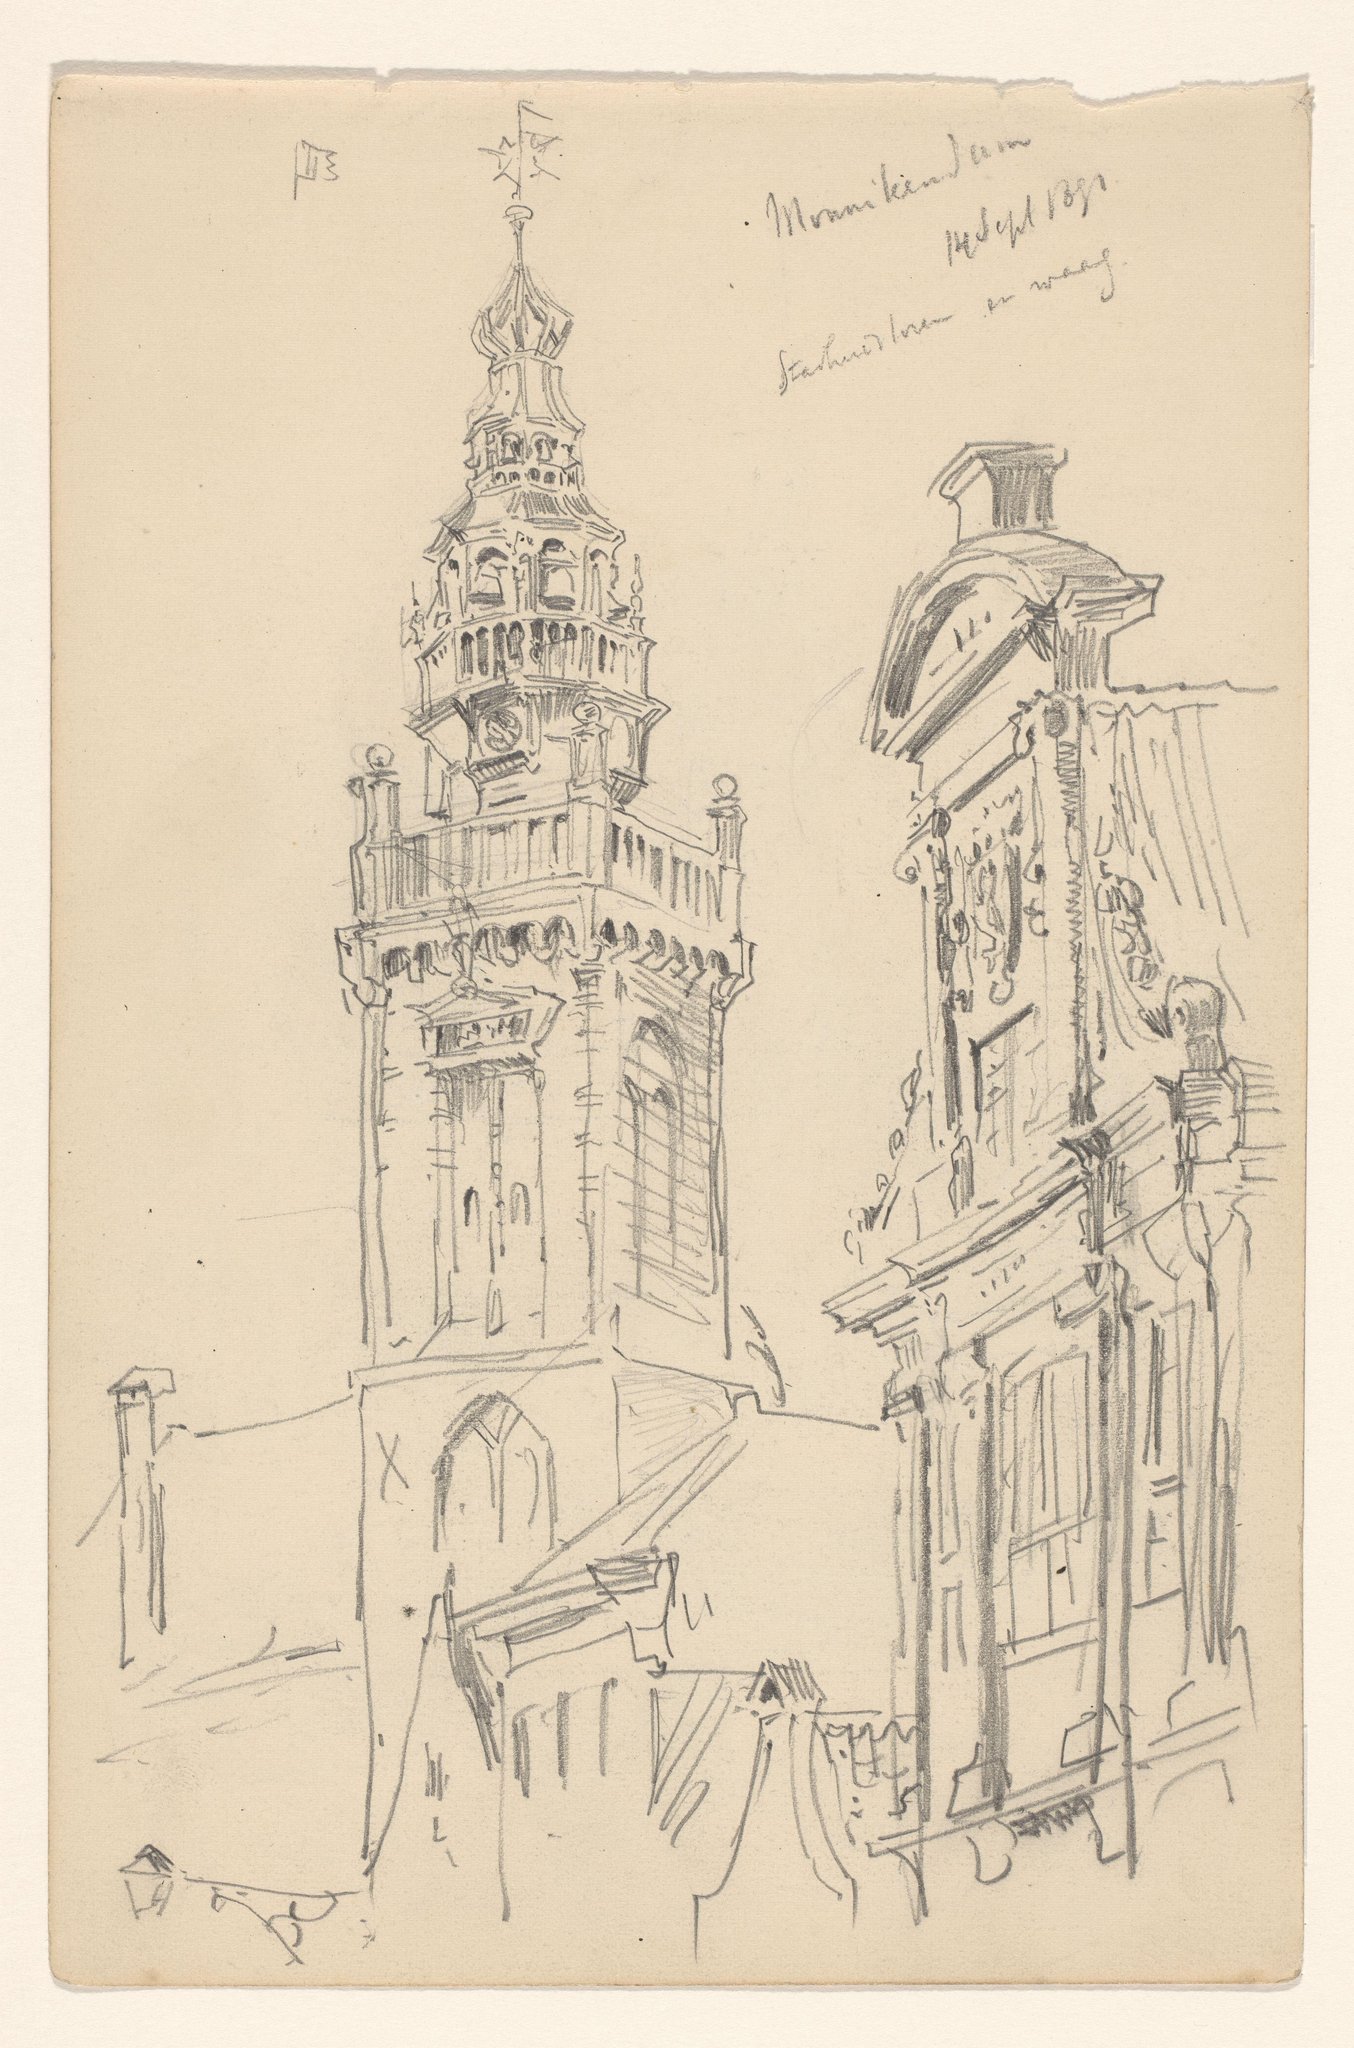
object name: drawing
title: Speeltoren en gevel van de Waag te Monnickendam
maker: jan hoynck van papendrecht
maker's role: draughtsman, painter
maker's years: 1858-1933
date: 1891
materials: paper, pencil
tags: tower, clock tower ~ monumental adornment, exterior ~ representation of a building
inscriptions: annotation: ‘Monnikendam/ 14 Sept 1891/ stadhuistoren en waag’